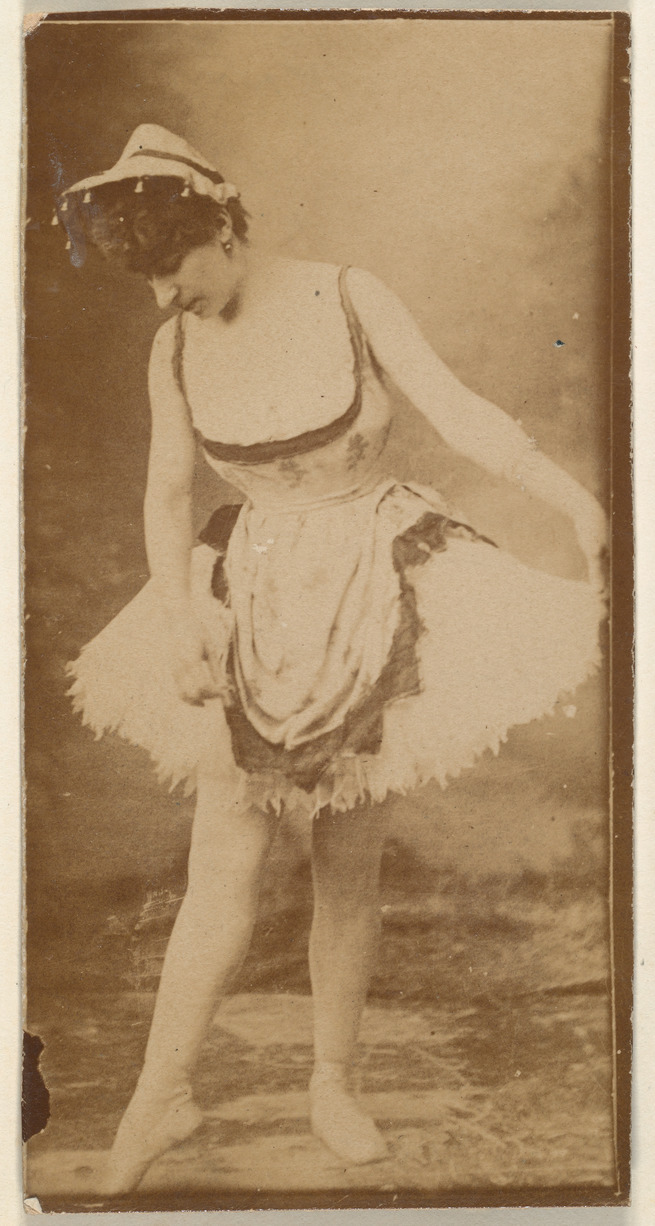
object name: photograph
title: Dancer standing with pointed toe, from the Actresses series (N668)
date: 1888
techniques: albumen silver print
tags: profiles,women,actresses,dancers